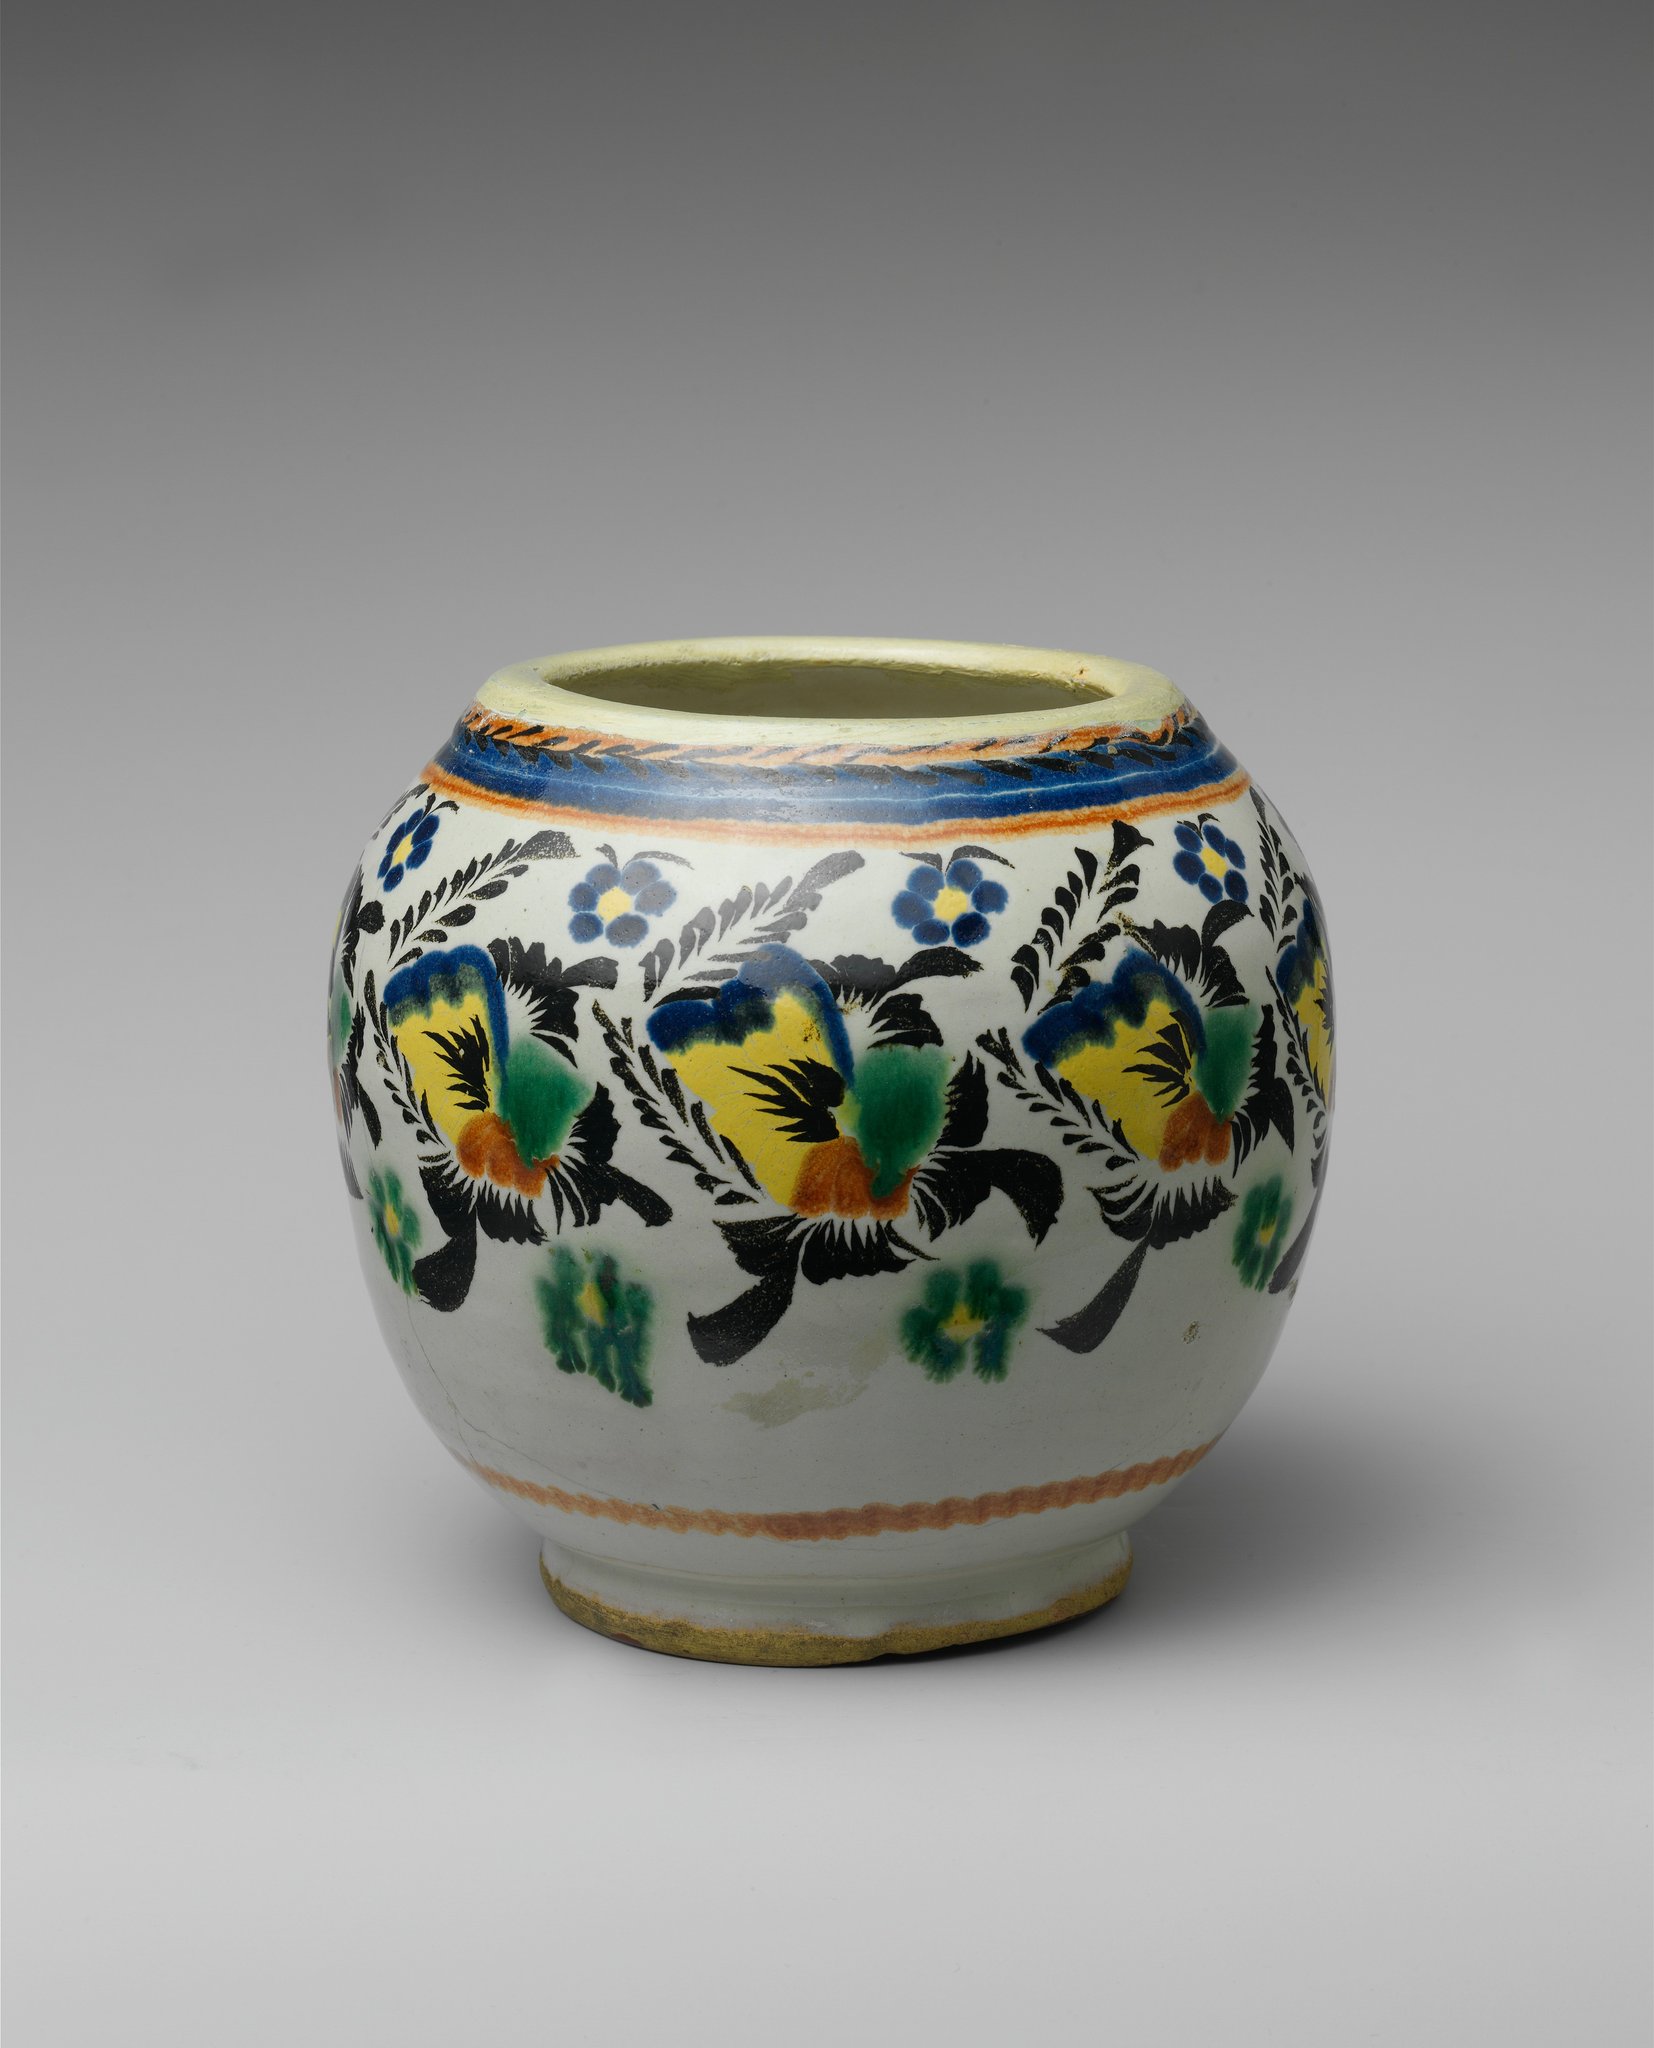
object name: jar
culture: mexican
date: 1850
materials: earthenware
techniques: glazing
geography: mexico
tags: flowers